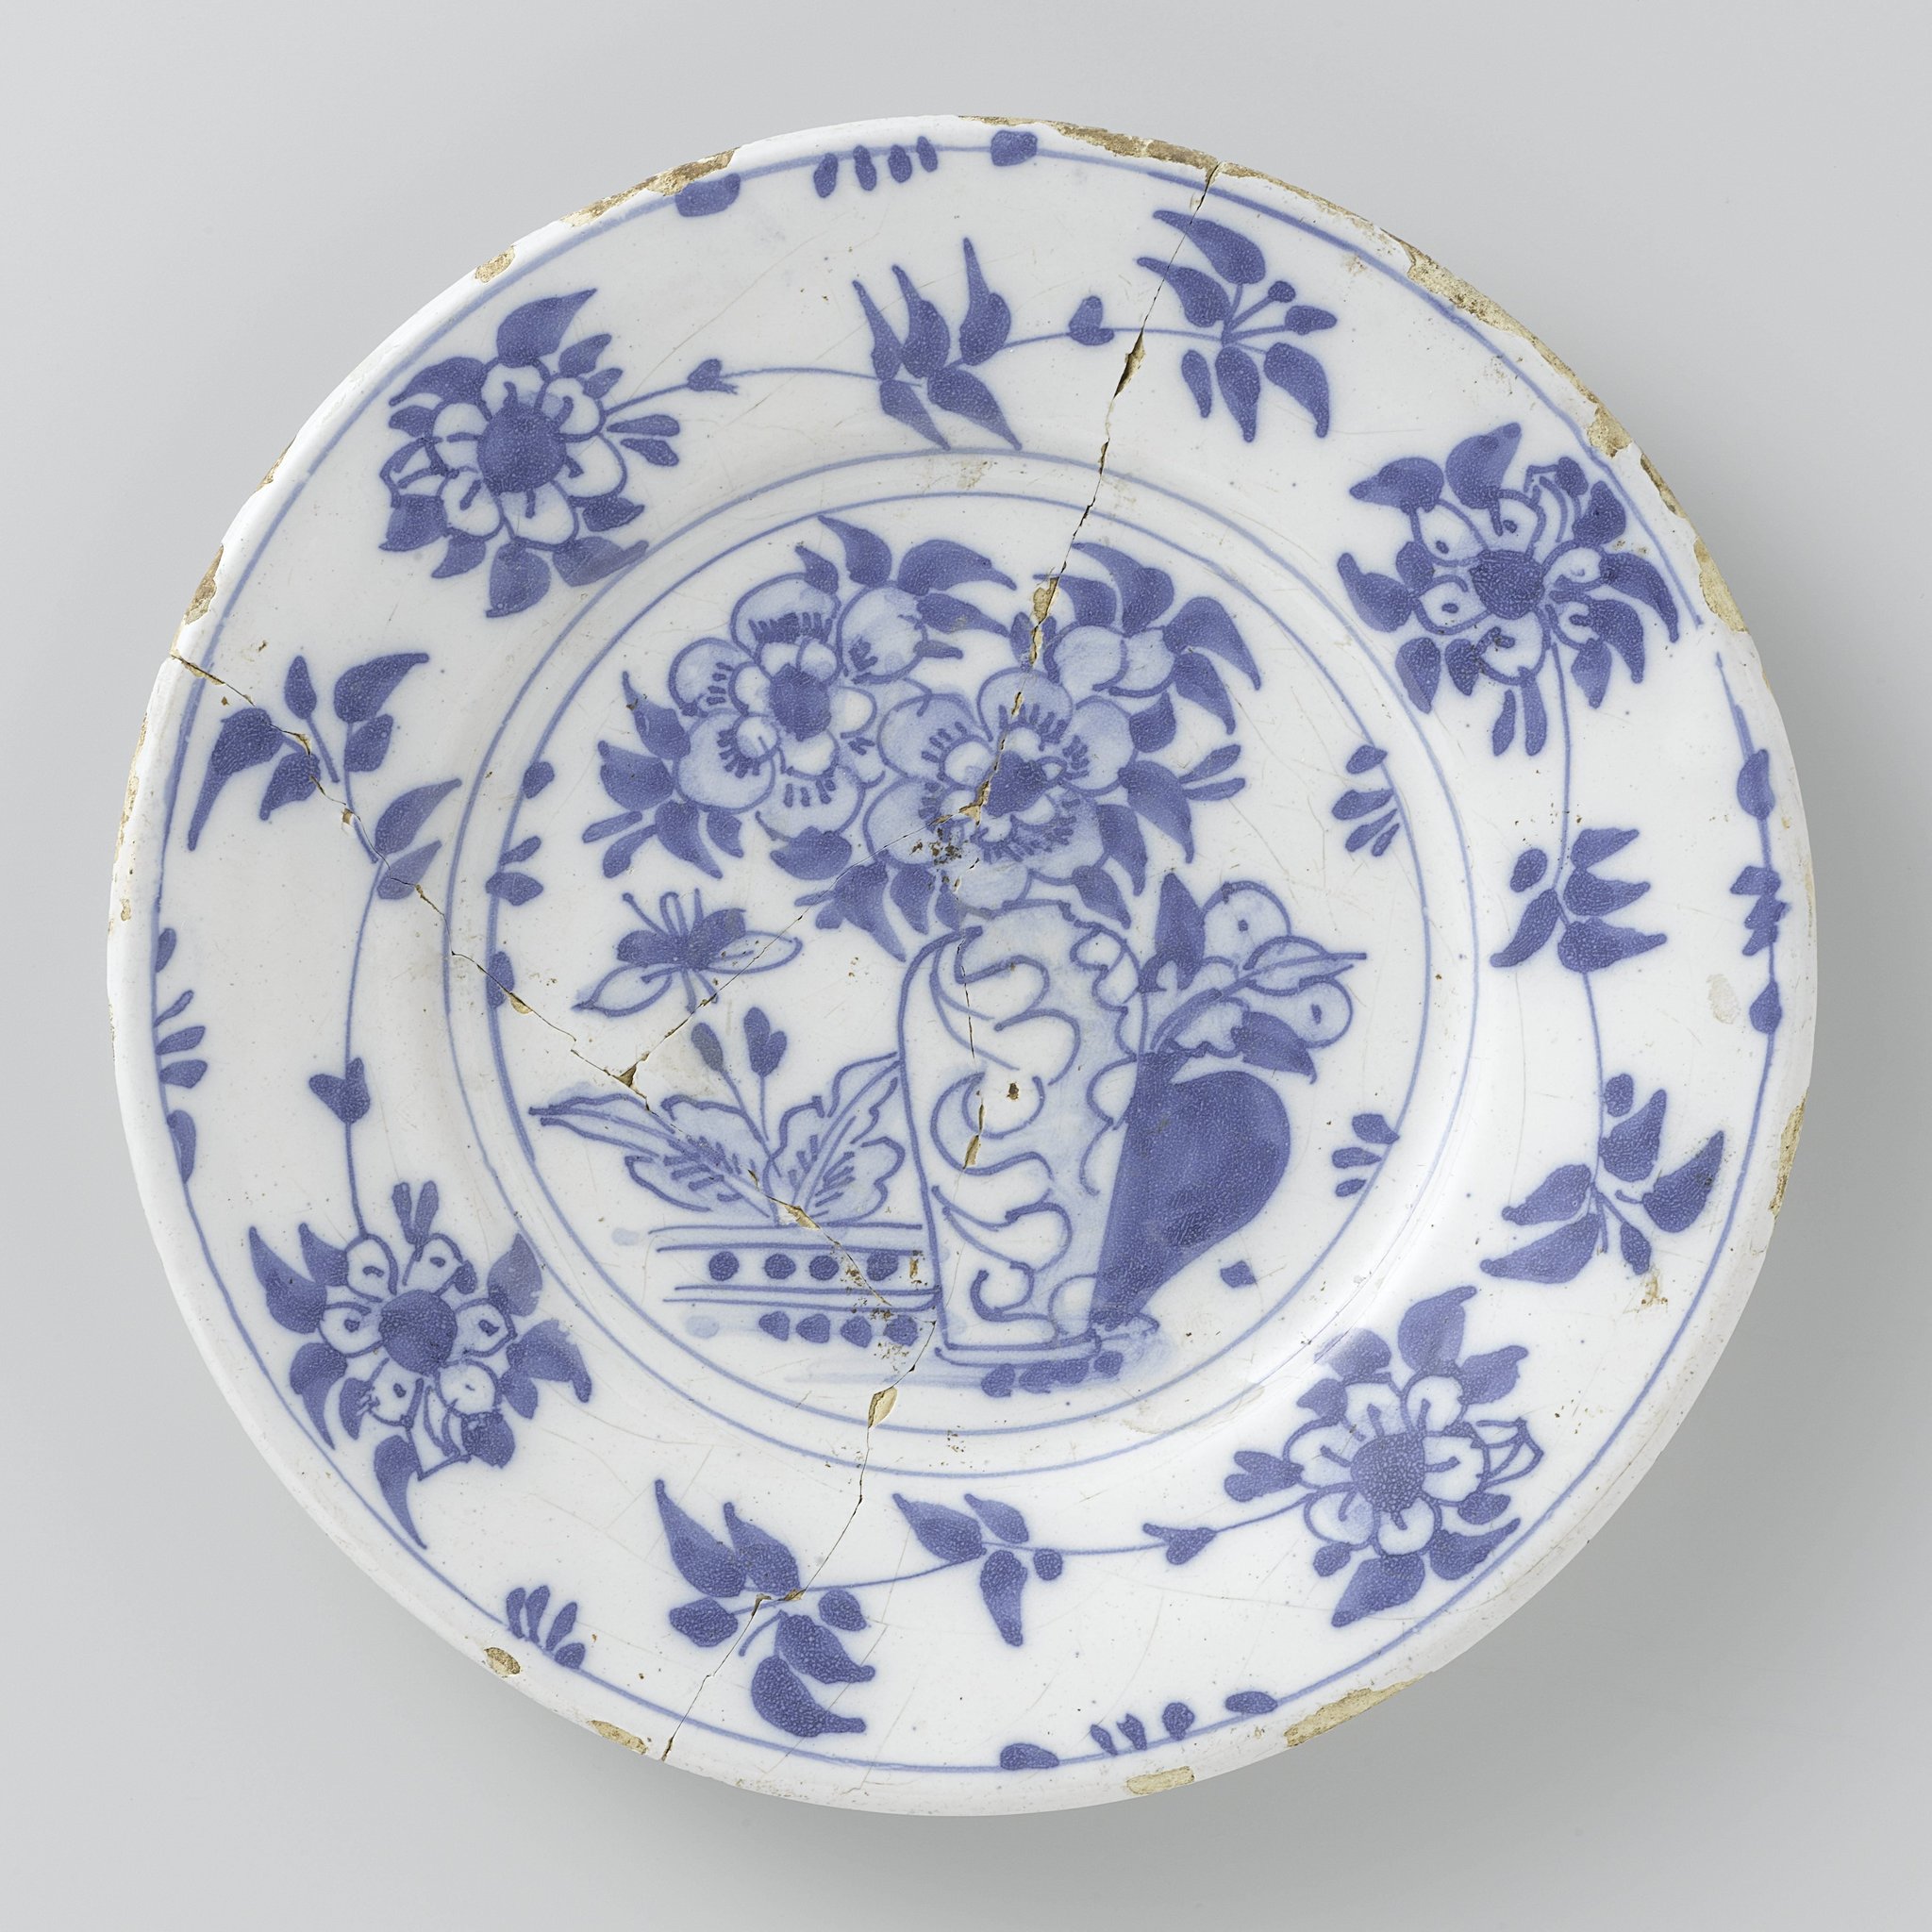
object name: plate dish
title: Bord, op het plat in blauw beschilderd met een vaas met bloemen. Rand: drie bloemtakken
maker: Anonymous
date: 1655-1670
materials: earthenware, glaze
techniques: painted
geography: delft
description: Bord van blauw beschilderde faience. Op het plat is een vaas met bloemen geschilderd en op de rand bloemtakken. Het bord is een bodemvondst.